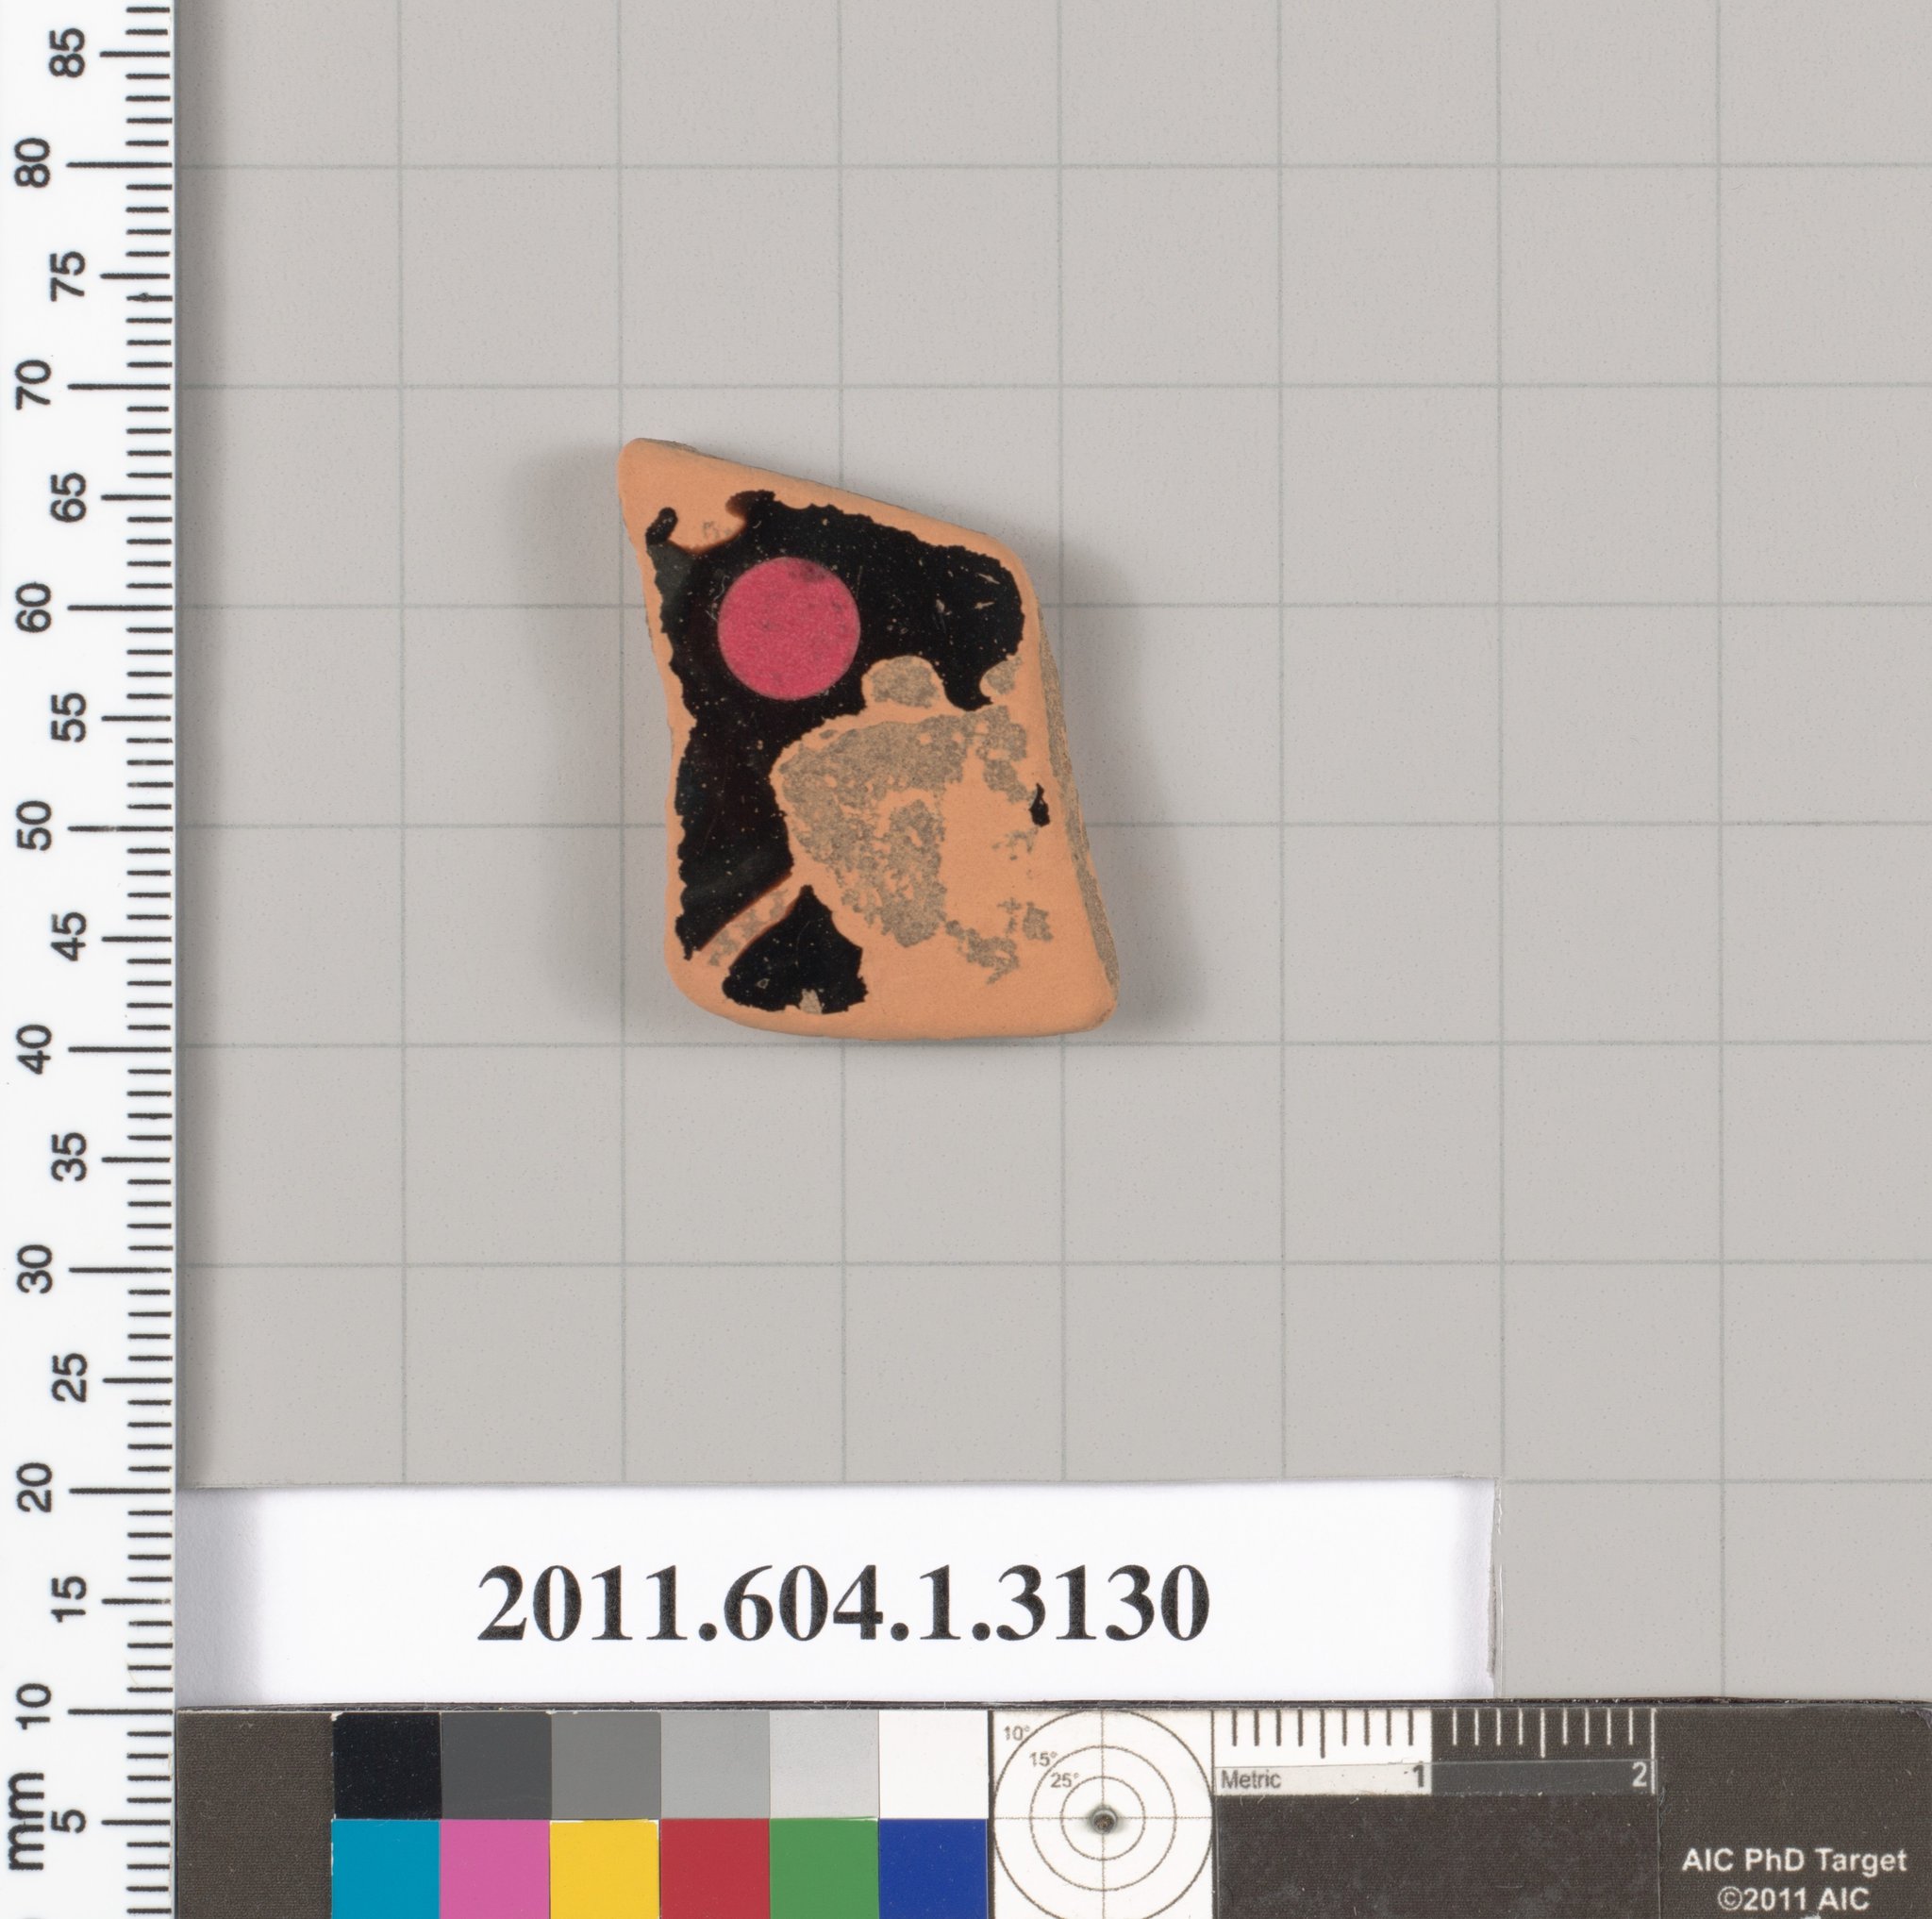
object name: kylix fragment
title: Terracotta fragment of a kylix (drinking cup)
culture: greek, attic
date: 500-451 BCE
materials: terracotta